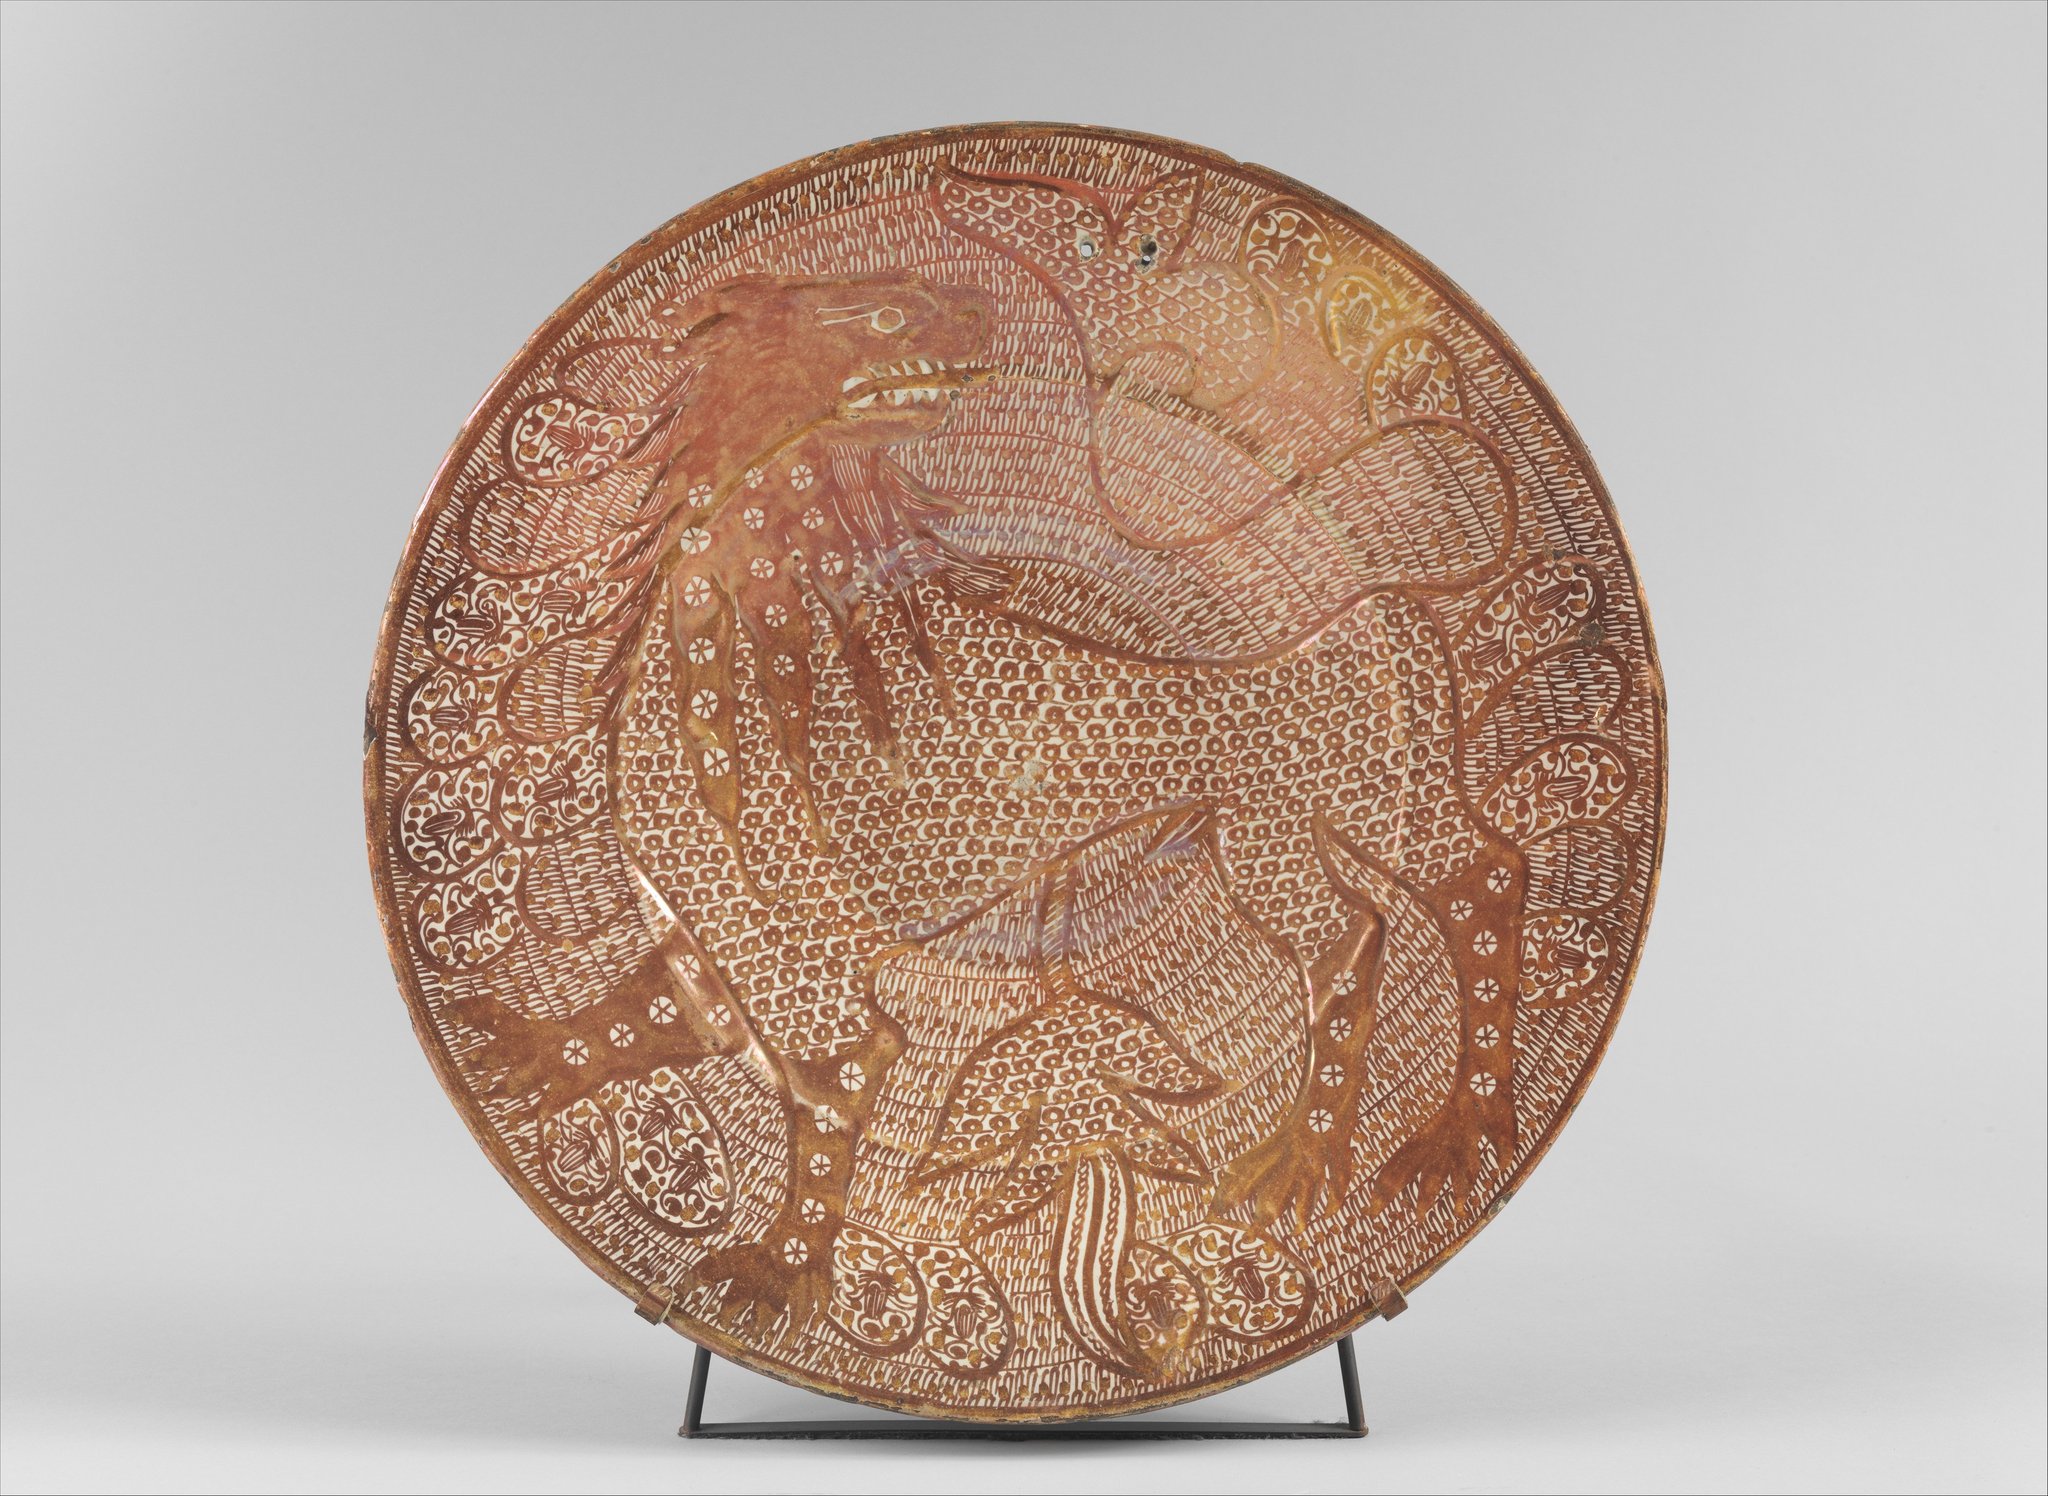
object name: dish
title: Dish with Lion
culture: spanish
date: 1500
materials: earthenware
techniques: glazing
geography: spain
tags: lions